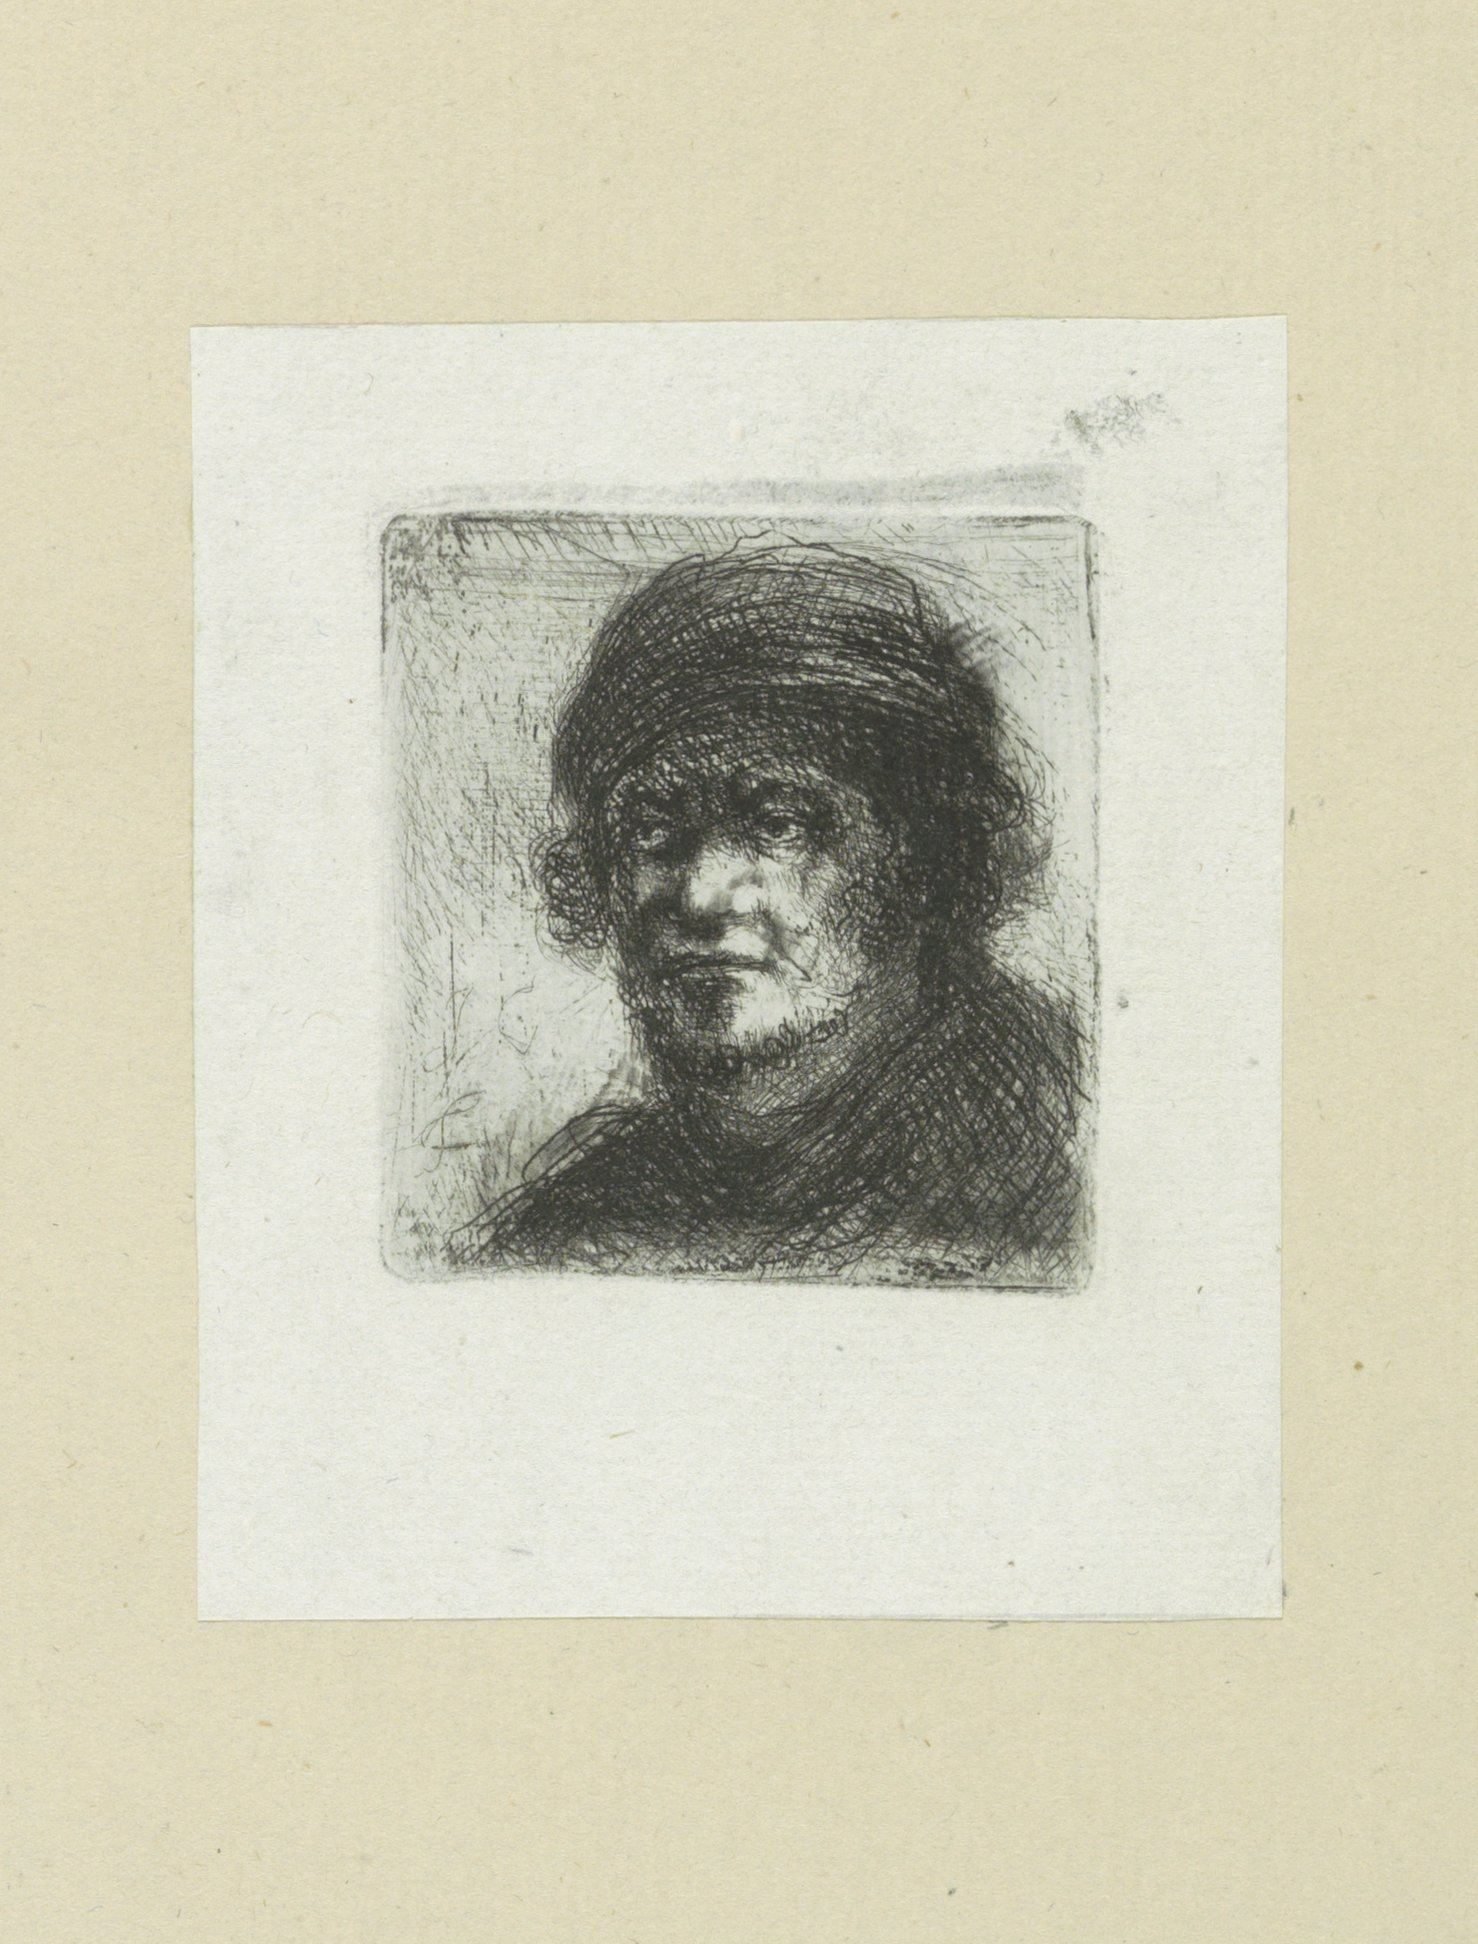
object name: print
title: The Compleat Work of Etchings by John Chalon / Oeuvre Complette des Eaux Fortes par Jean Chalon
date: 1802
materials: paper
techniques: drypoint, etching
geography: london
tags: head-gear: cap (+ men's clothes), morphology of human expression (+ adult male (human being))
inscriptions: collector's mark: ‘B’, collector's mark: ‘RIJKS / MUSM’